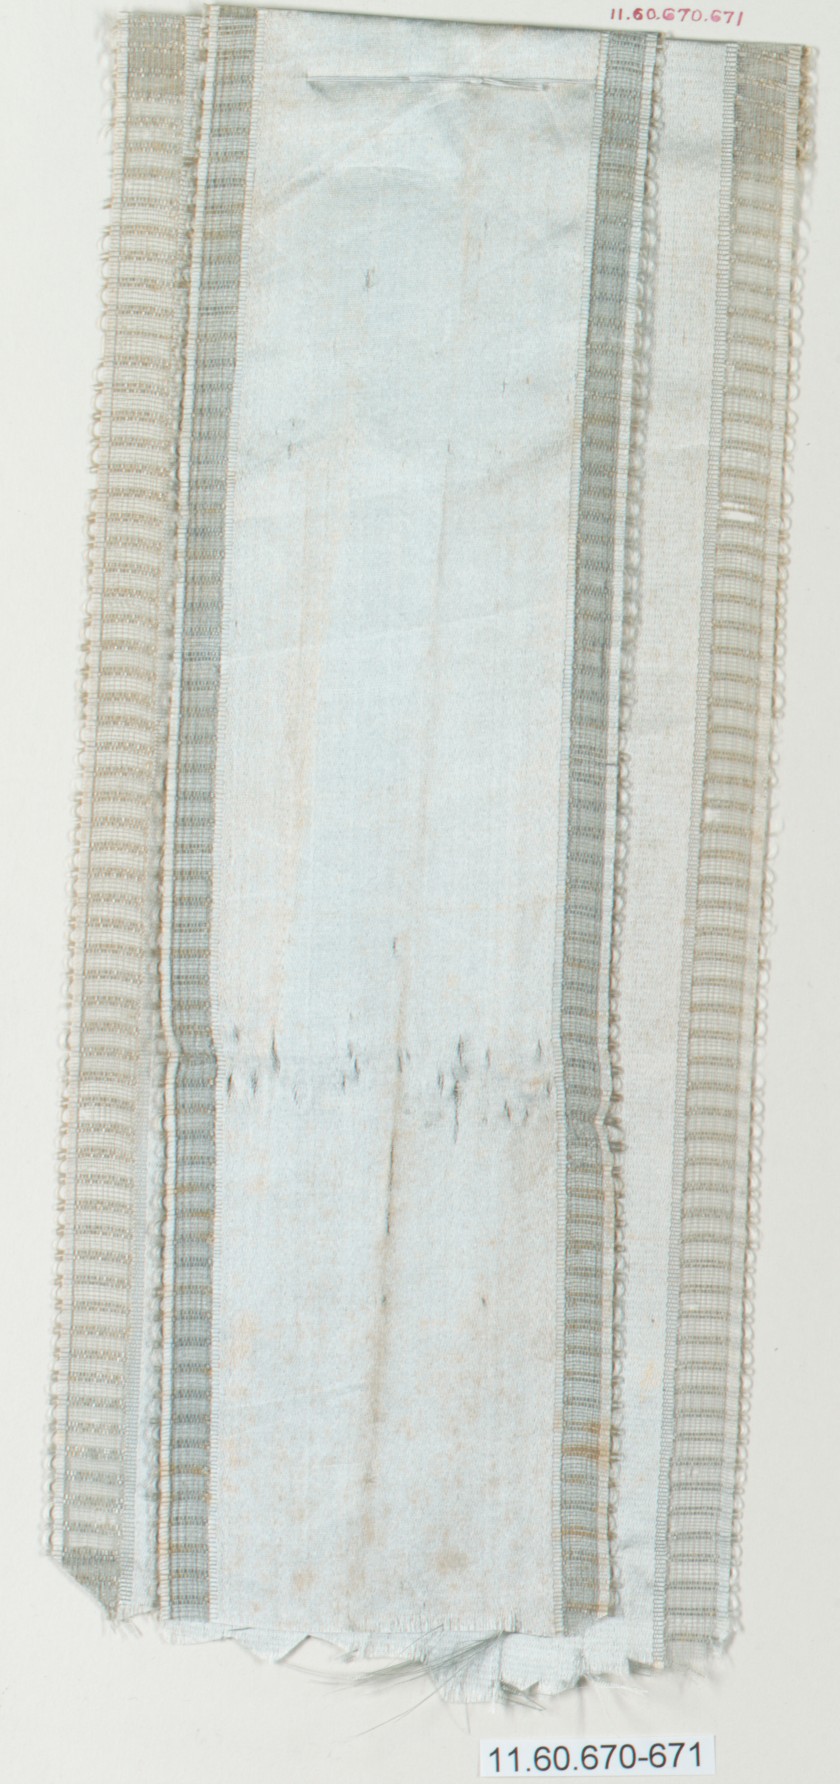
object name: ribbon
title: Ribbons (2)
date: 1801-1900